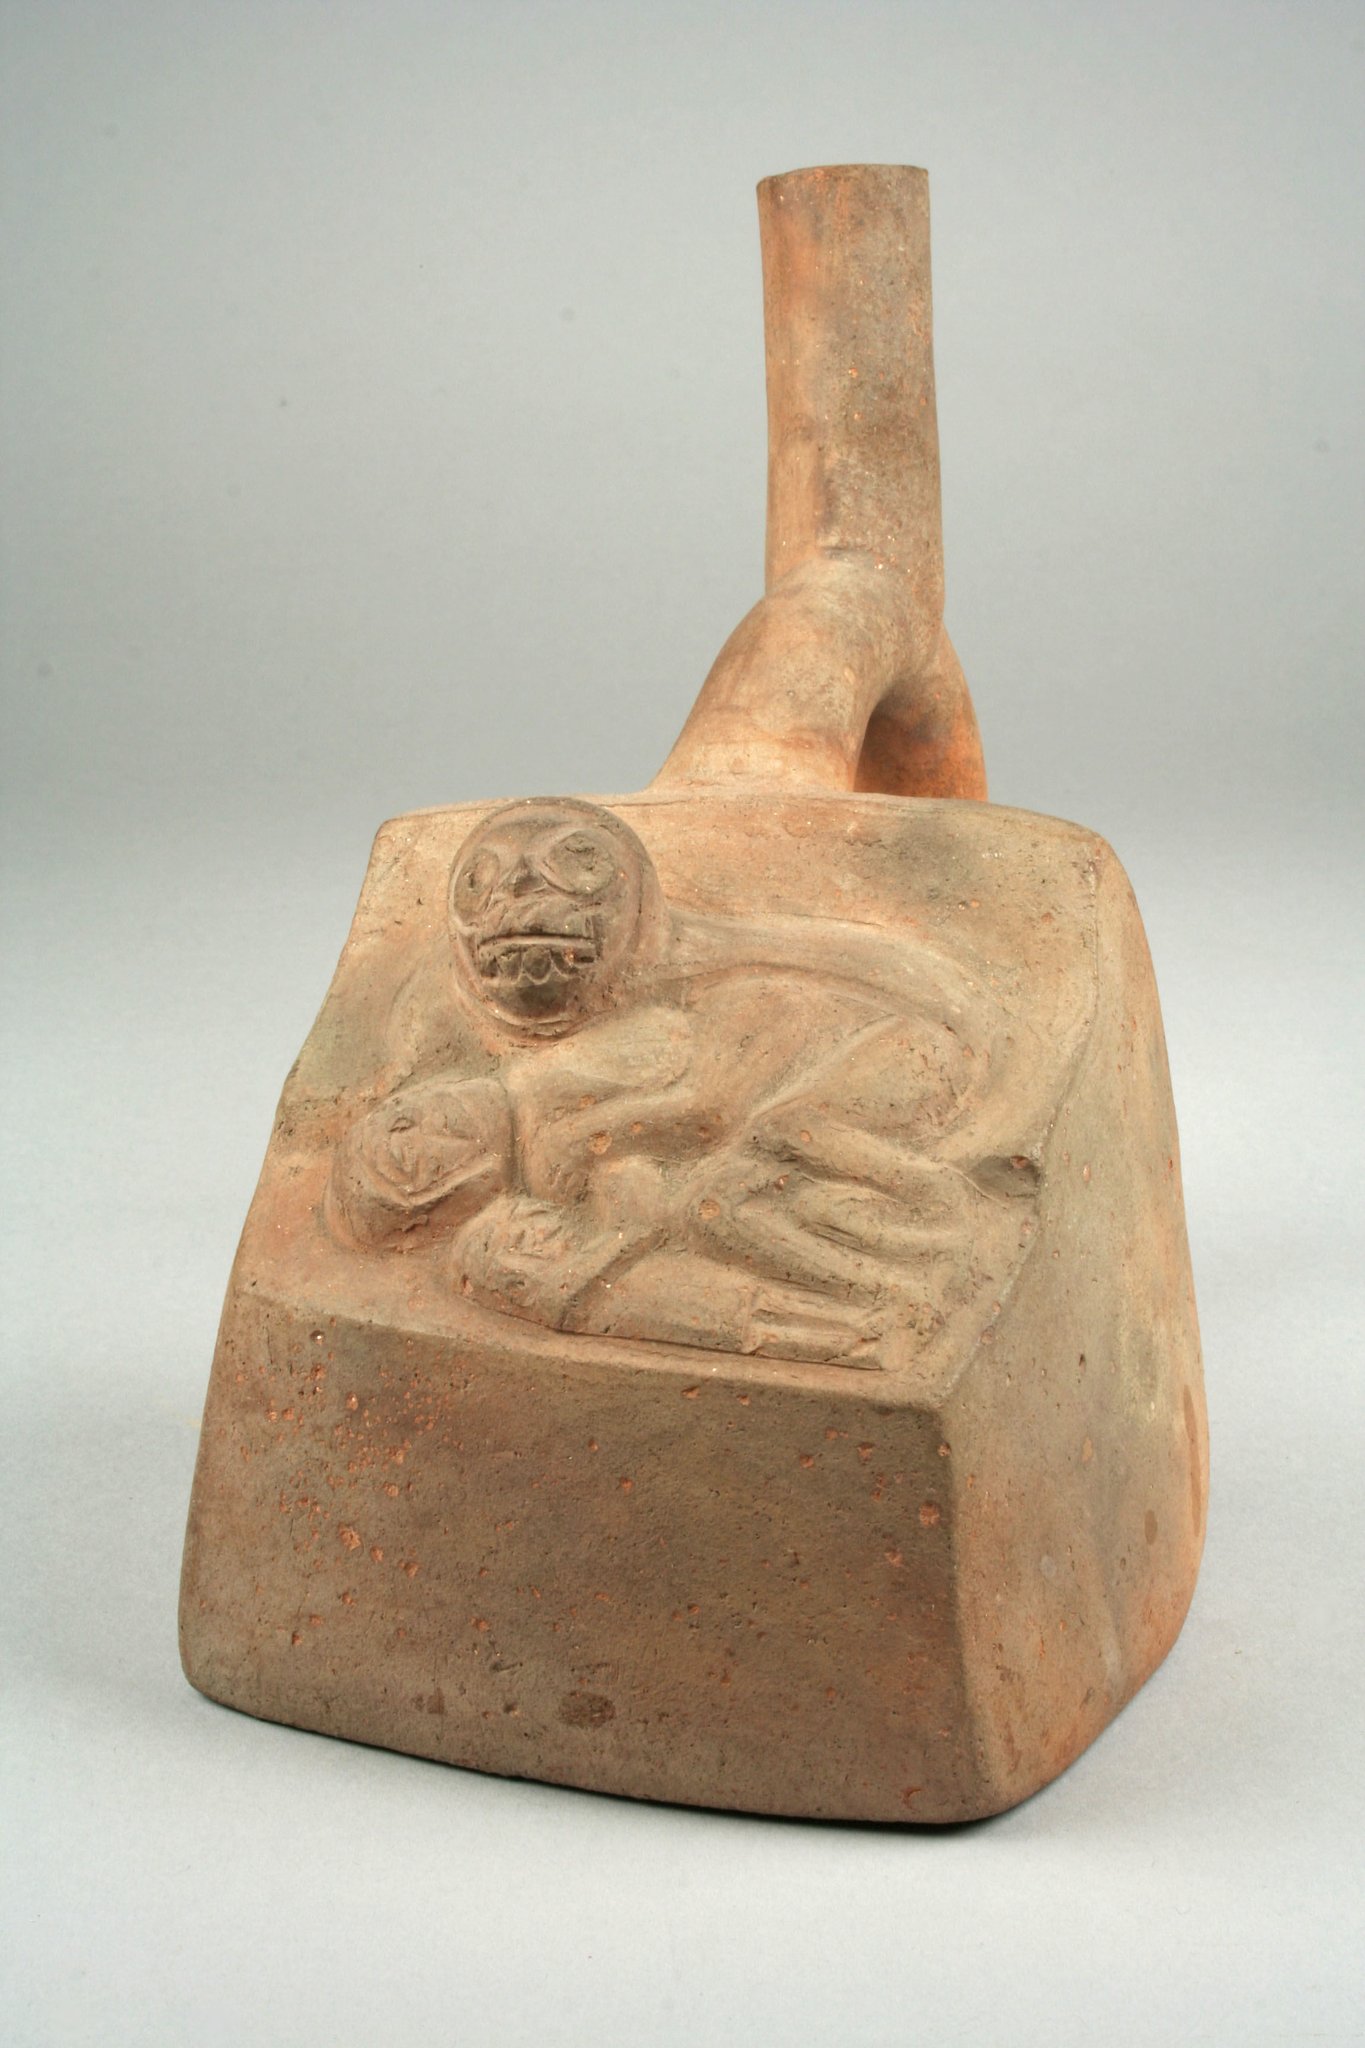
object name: bottle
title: Bottle, Death Scene (?)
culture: moche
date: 201-600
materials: ceramic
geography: peru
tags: human figures,death